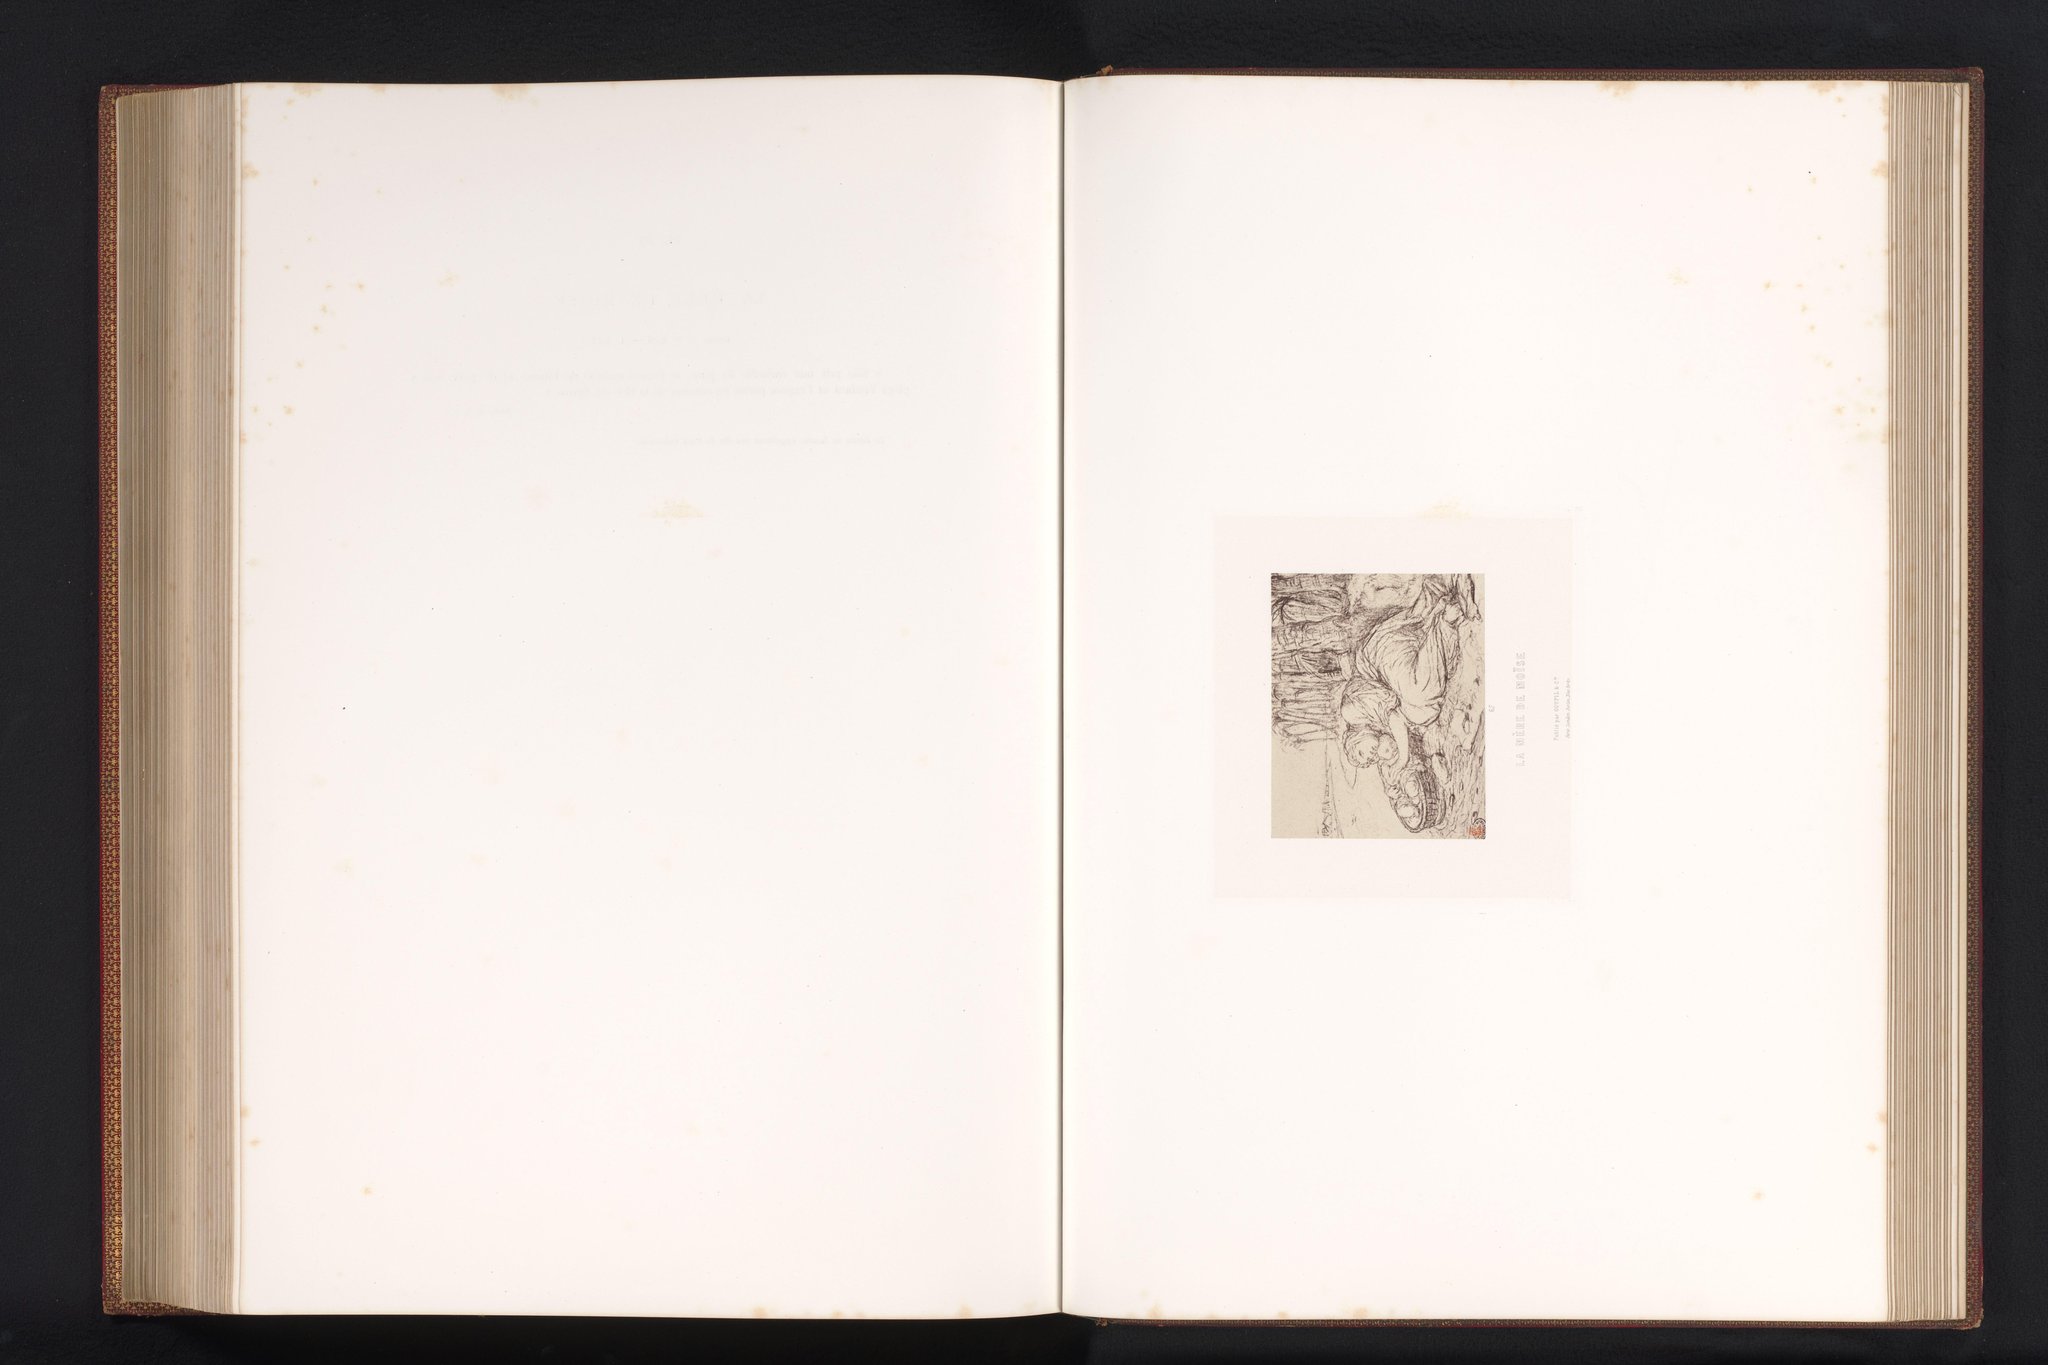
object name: photograph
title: La mère de Moïse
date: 1853-1858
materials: paper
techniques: albumen print, engraving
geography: paris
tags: jochebed makes an ark (or basket) of bulrushes daubed with pitch and puts moses in it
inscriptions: initials: ‘GC’